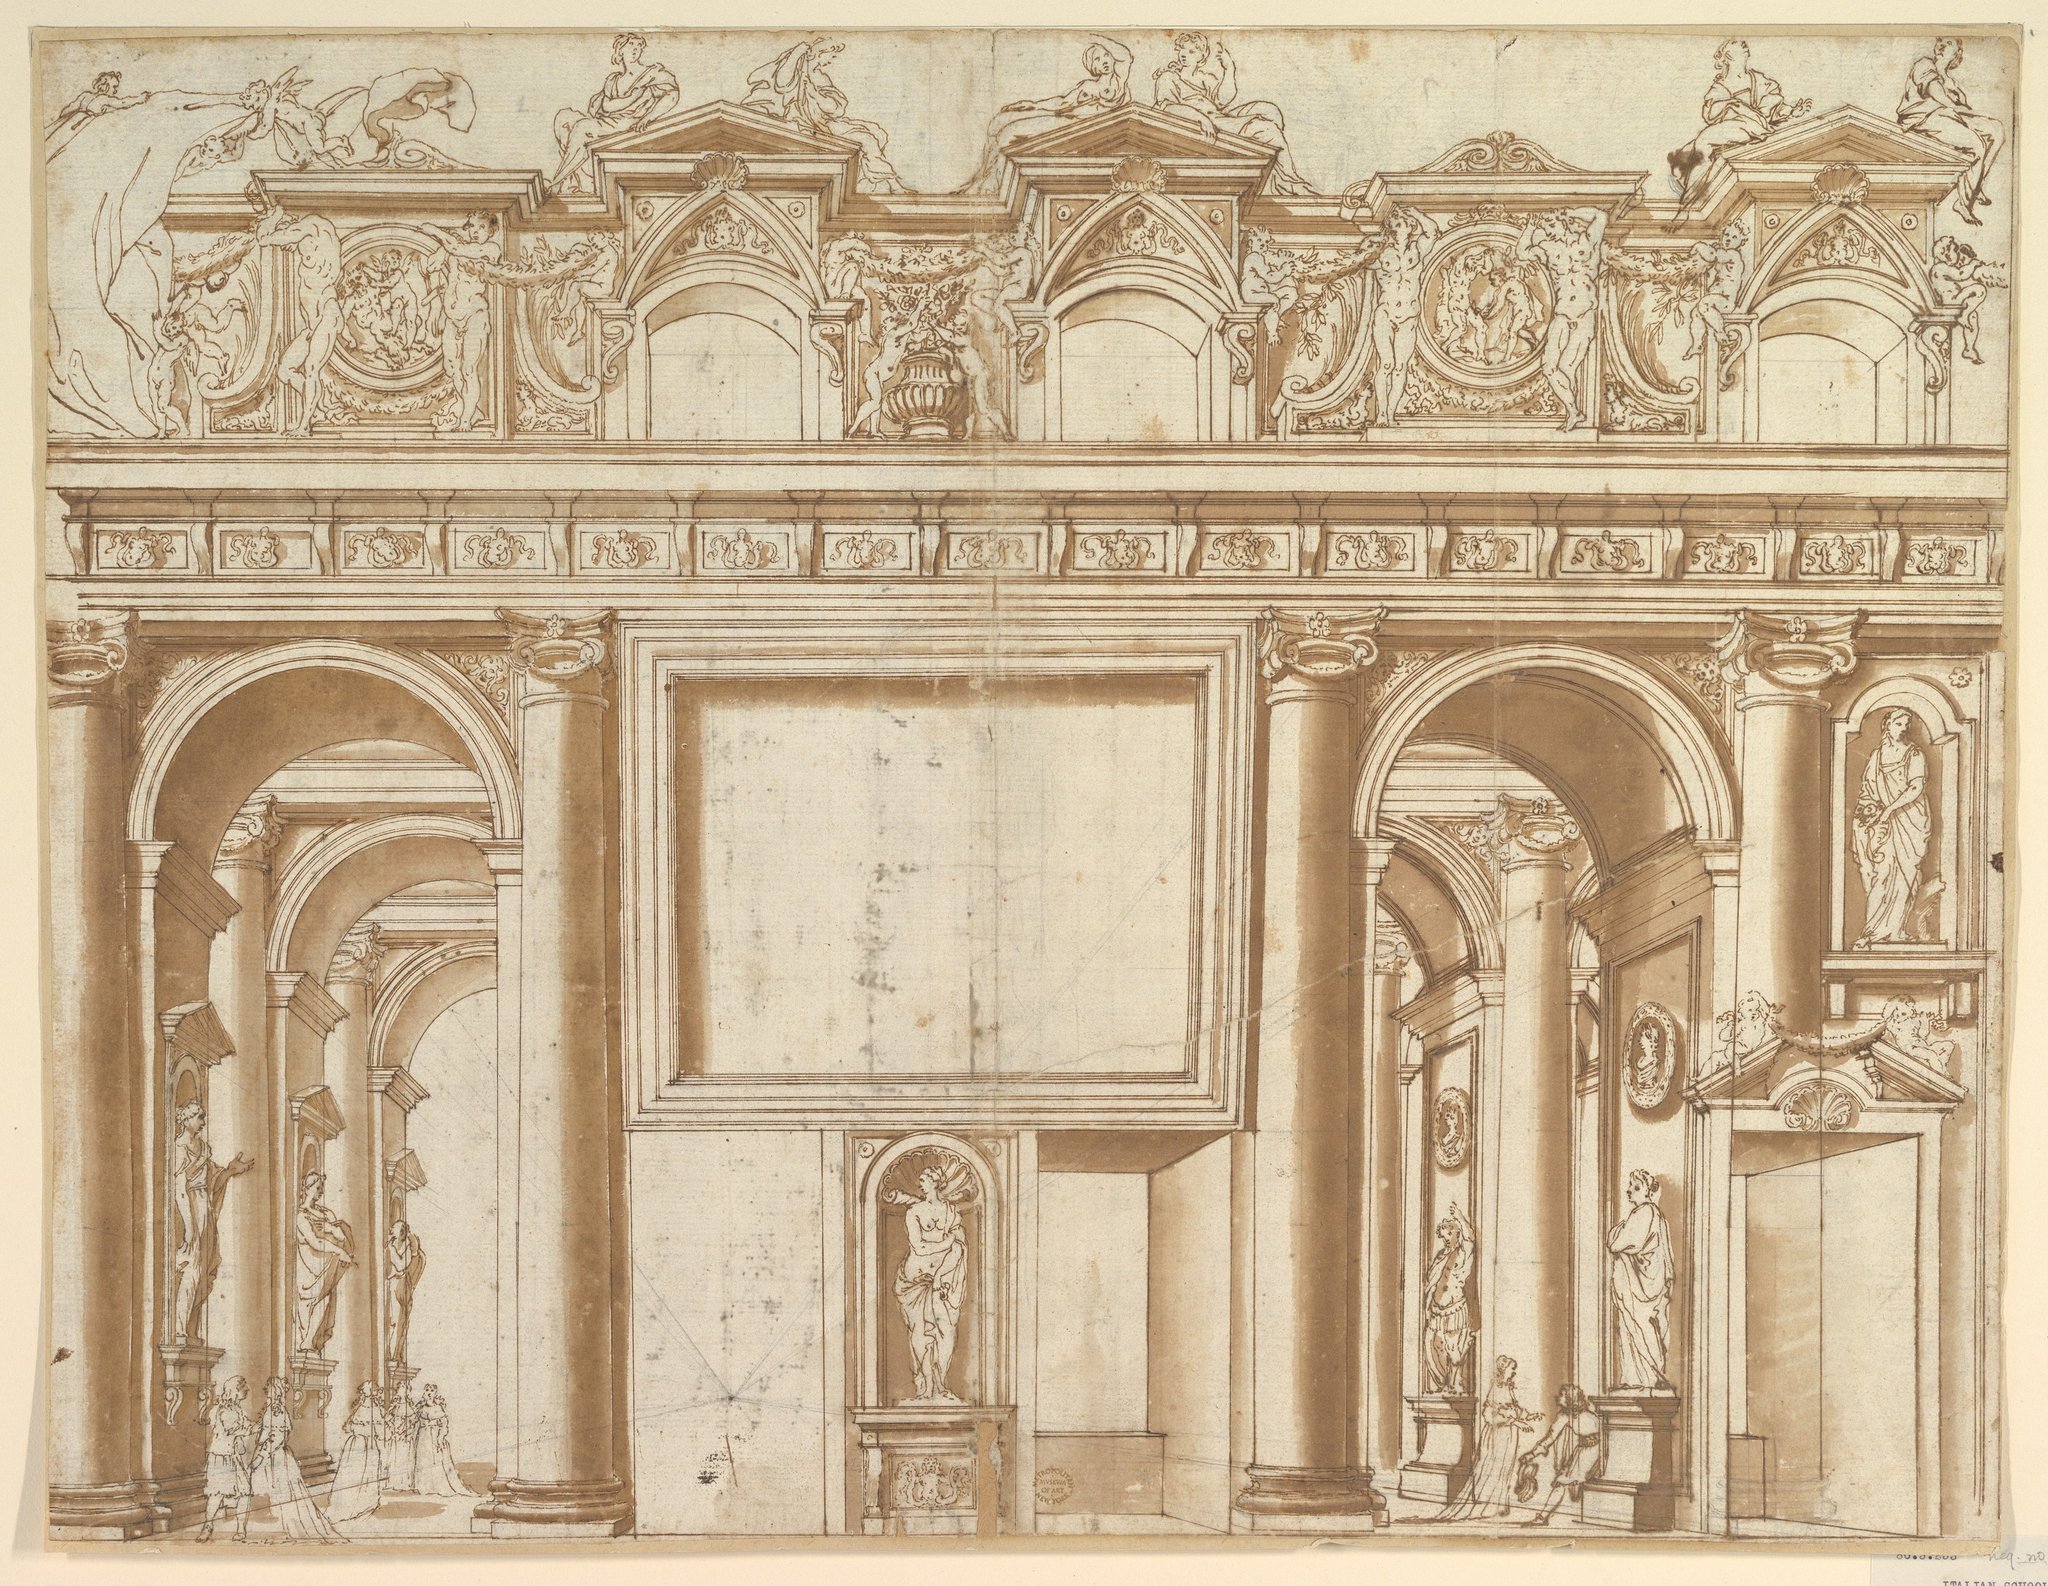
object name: drawing ornament architecture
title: Architectural Design or Stage Set for the Colonna Family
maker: anonymous, italian, 16th century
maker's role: artist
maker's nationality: italian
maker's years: 1550-1600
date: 1501-1600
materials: ink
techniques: pen, wash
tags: stage design